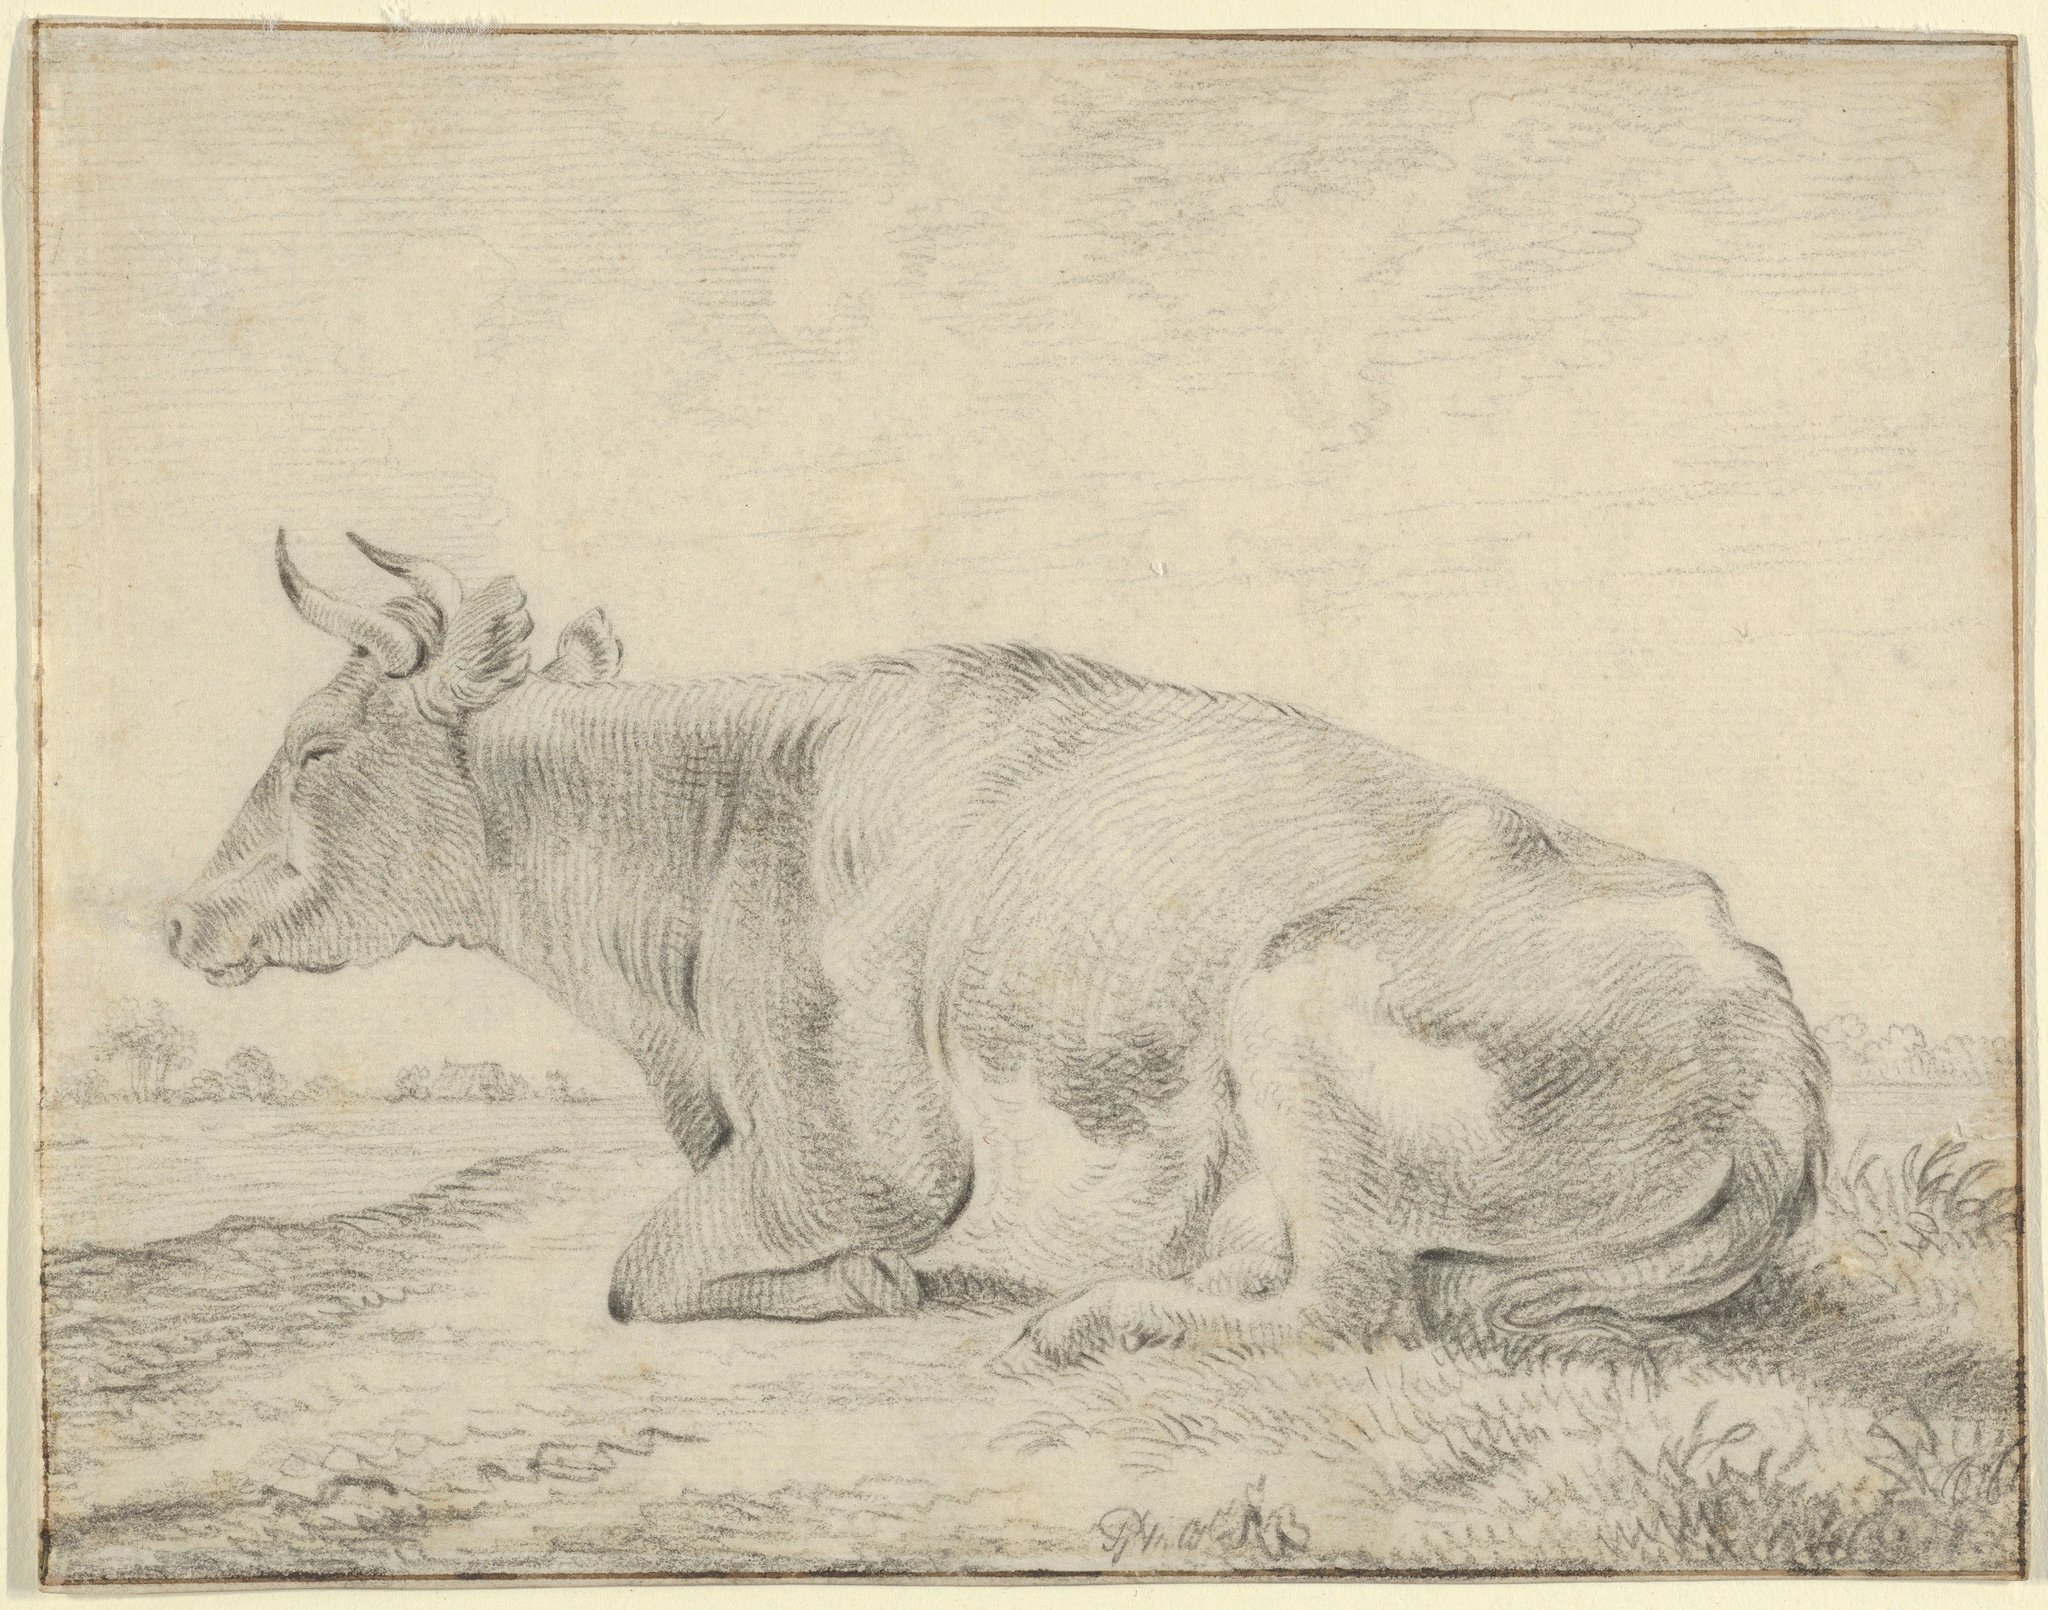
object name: drawing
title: A Cow Lying in a Landscape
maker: pieter gerardus van os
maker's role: artist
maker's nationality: dutch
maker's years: 1776-1836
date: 1801-1833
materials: chalk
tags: cows